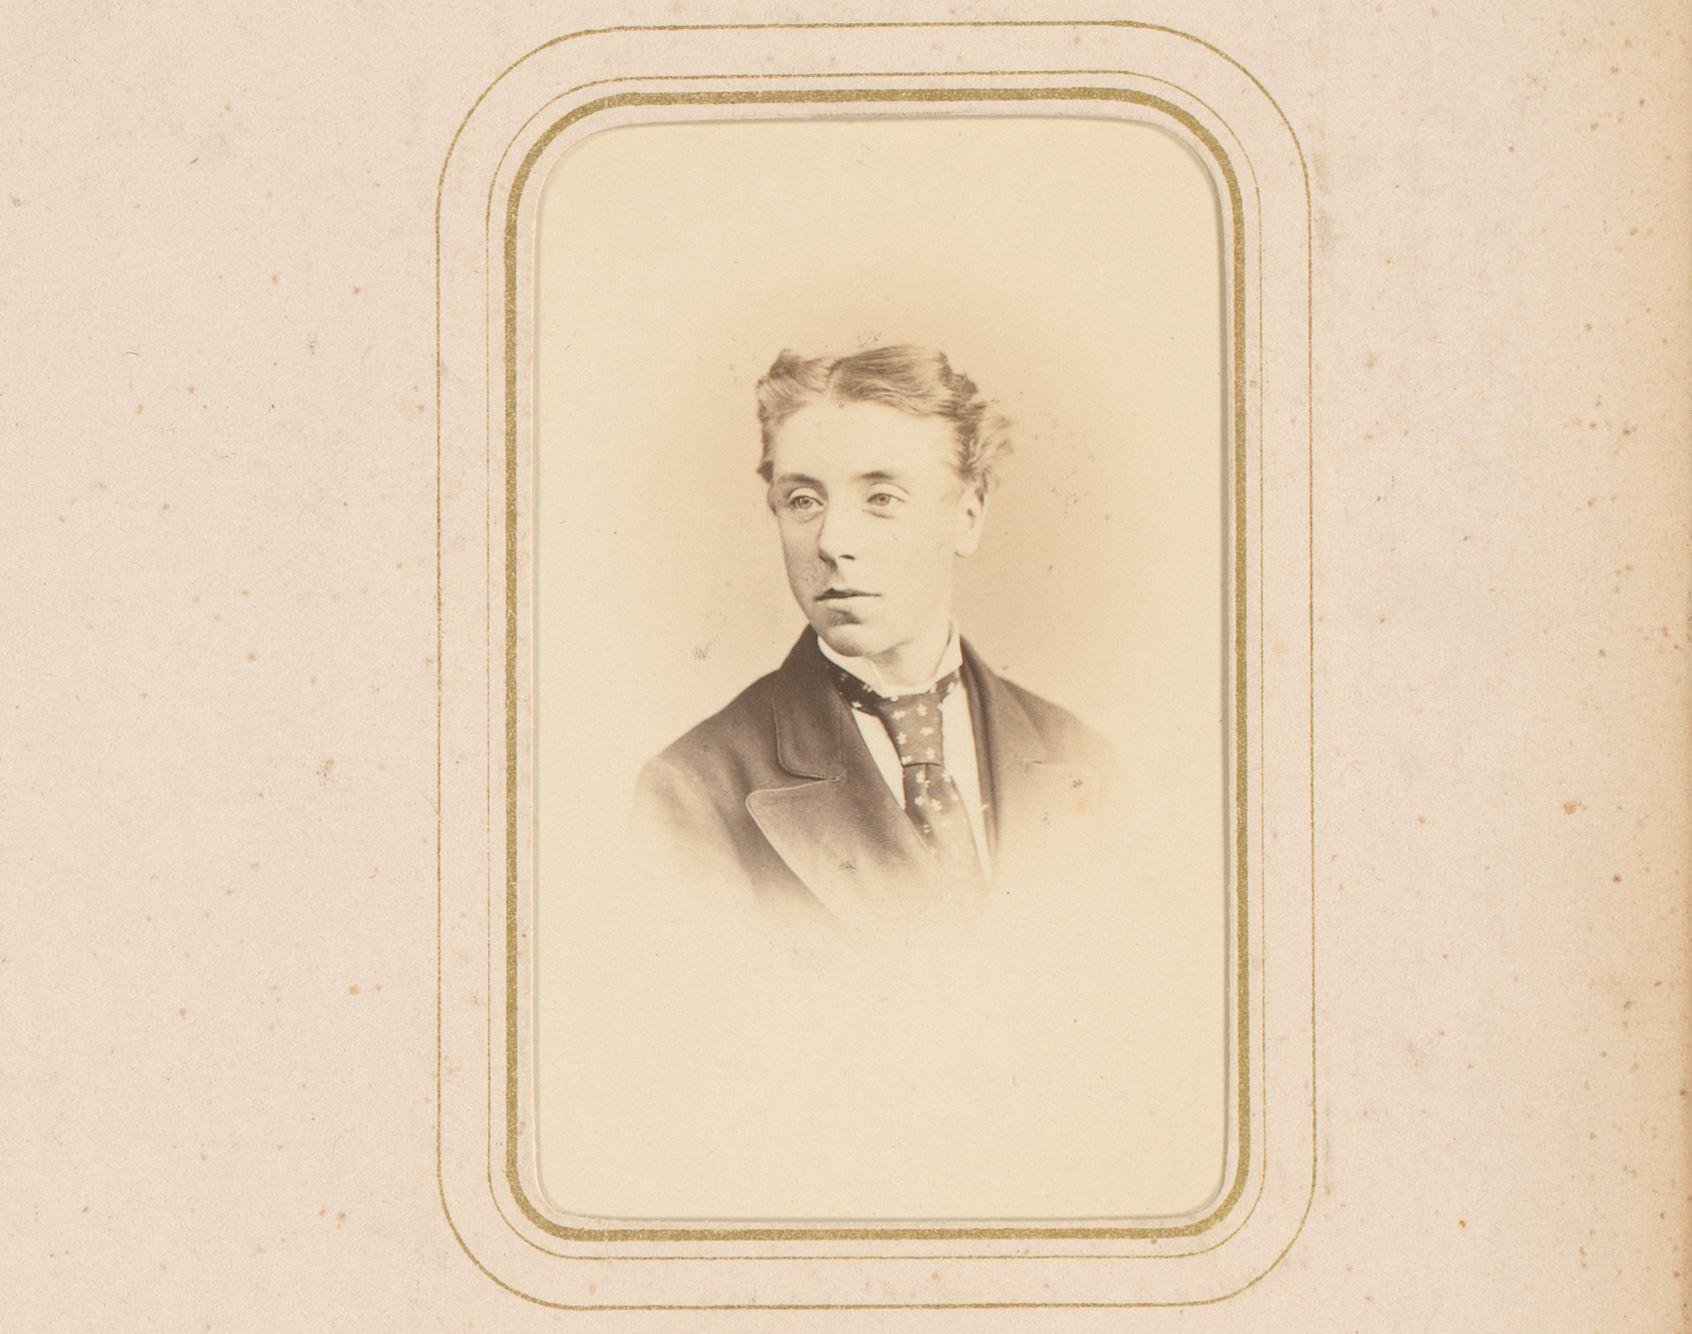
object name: carte de visite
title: Portret van een jonge man met stropdas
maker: richard boning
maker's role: fotograaf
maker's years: 1826-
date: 1810-1870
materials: cardboard, photographic support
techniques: albumen print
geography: hastings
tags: historical persons, youth, adolescent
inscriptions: date: ‘October 1870.’, inscription: ‘No 11032/ R. BONING/ 10, VERULAM PLACE ST LEONARDS on SEA/ THIS PICTURE CAN BE ENLARGED TO/ ANY SIZE, AND A VALUABLE PAINTING/ PRODUCED ON PAPER OR CANVASS/ PRODUCED ON PAPER OR CANVASS/ THE LIKENESS CANNOT FAIL TO BE CORRECT’